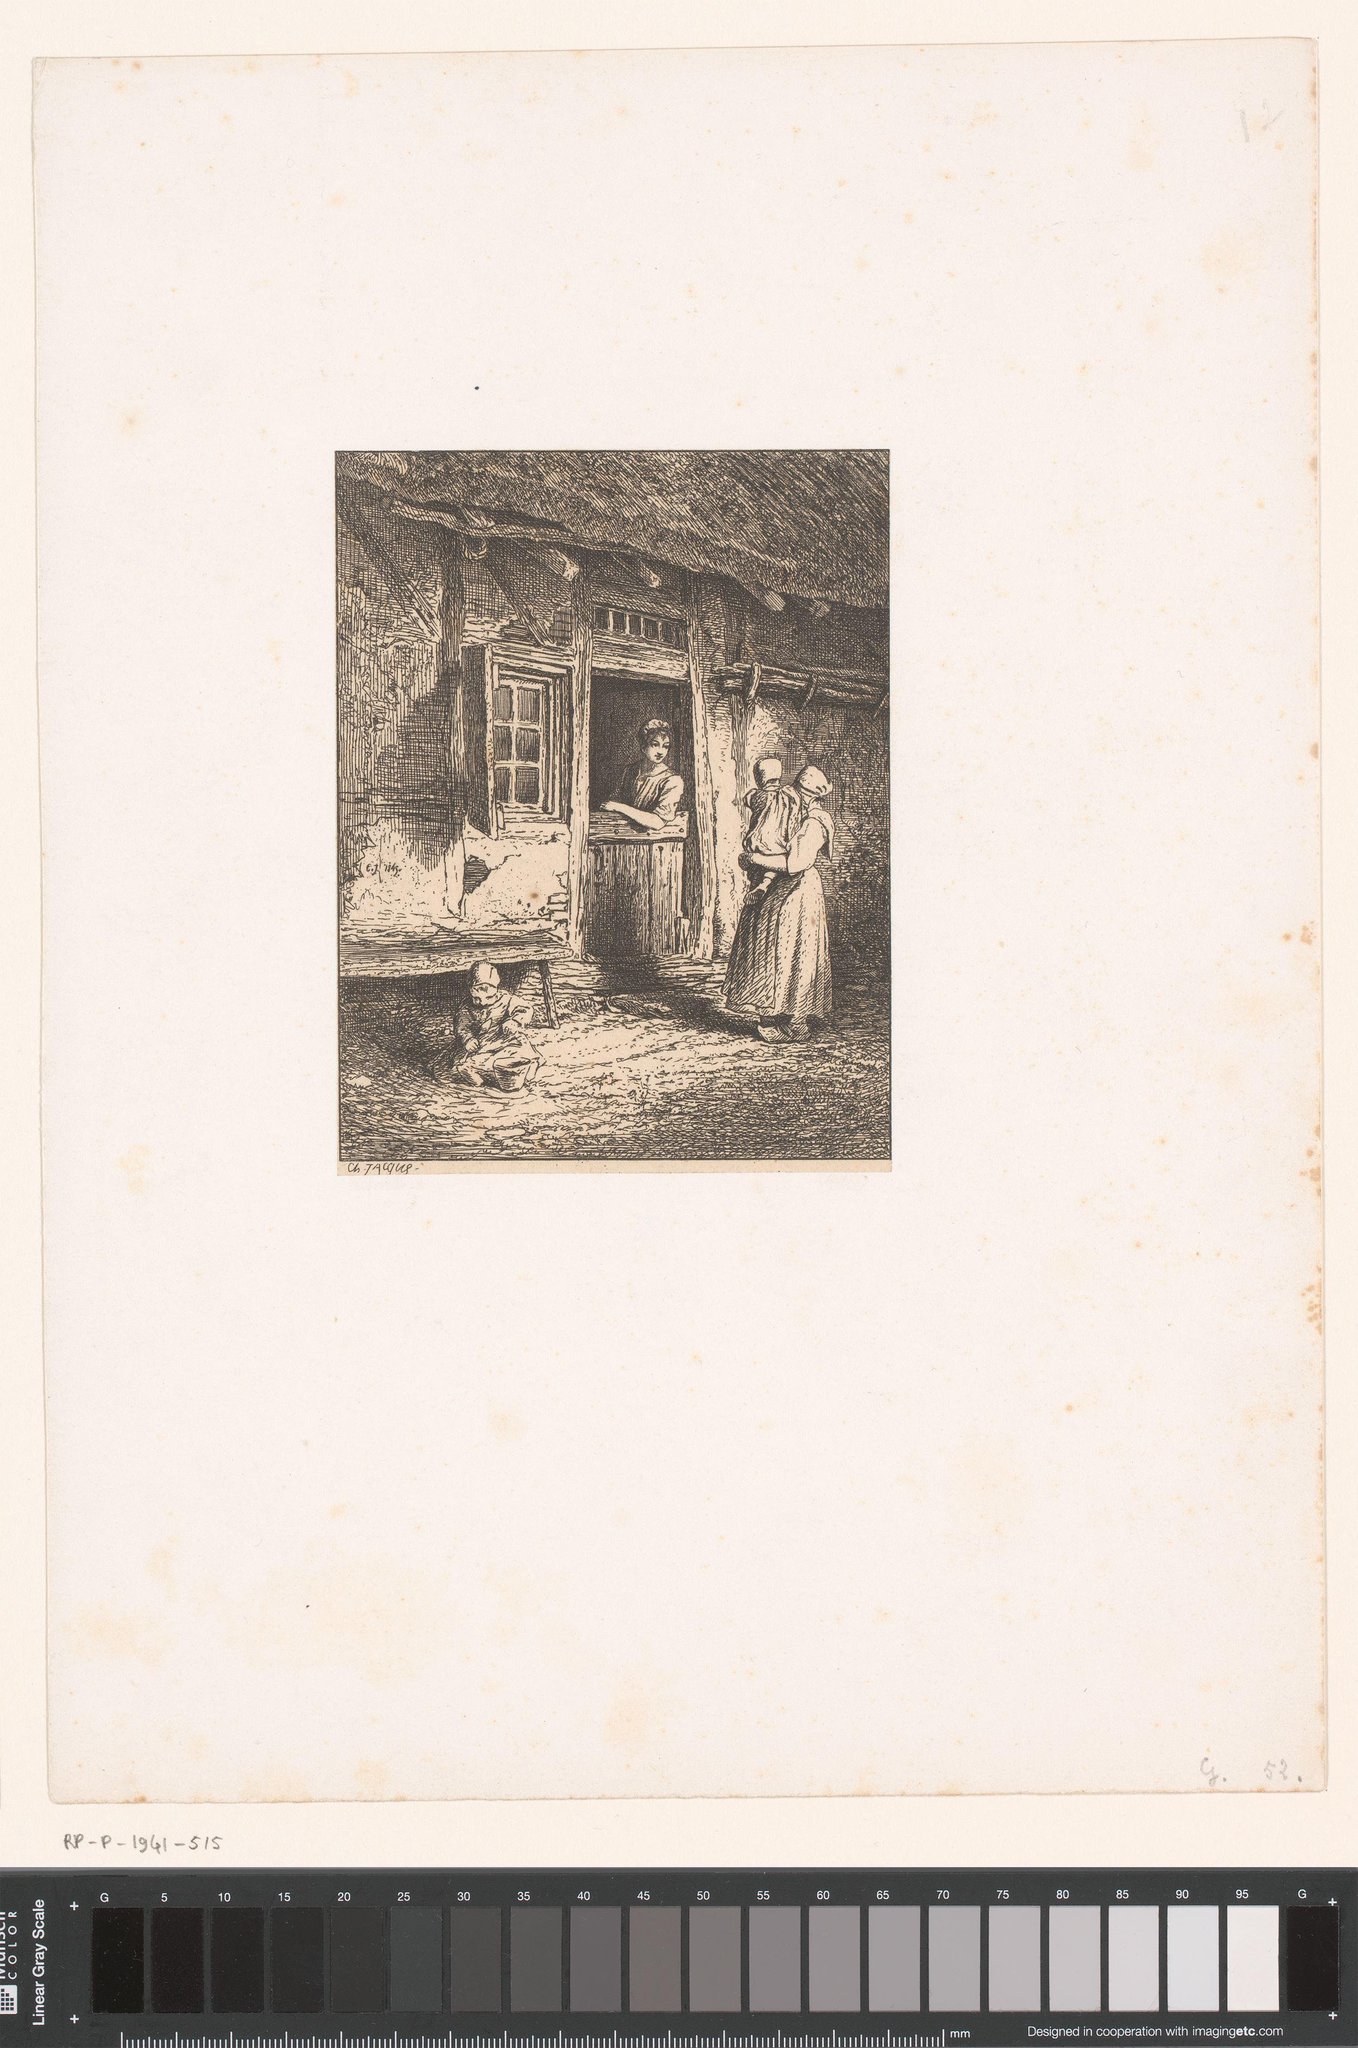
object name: print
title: Twee vrouwen met kinderen bij de deur van een boerderij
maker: charles emile jacque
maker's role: draughtsman, painter, print maker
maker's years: 1813-1894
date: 1845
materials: paper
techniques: etching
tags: divided door, upper part opened, mother and baby or young child, farm or solitary house in landscape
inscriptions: collector's mark: Lugt 2228, collector's mark: Lugt 2760